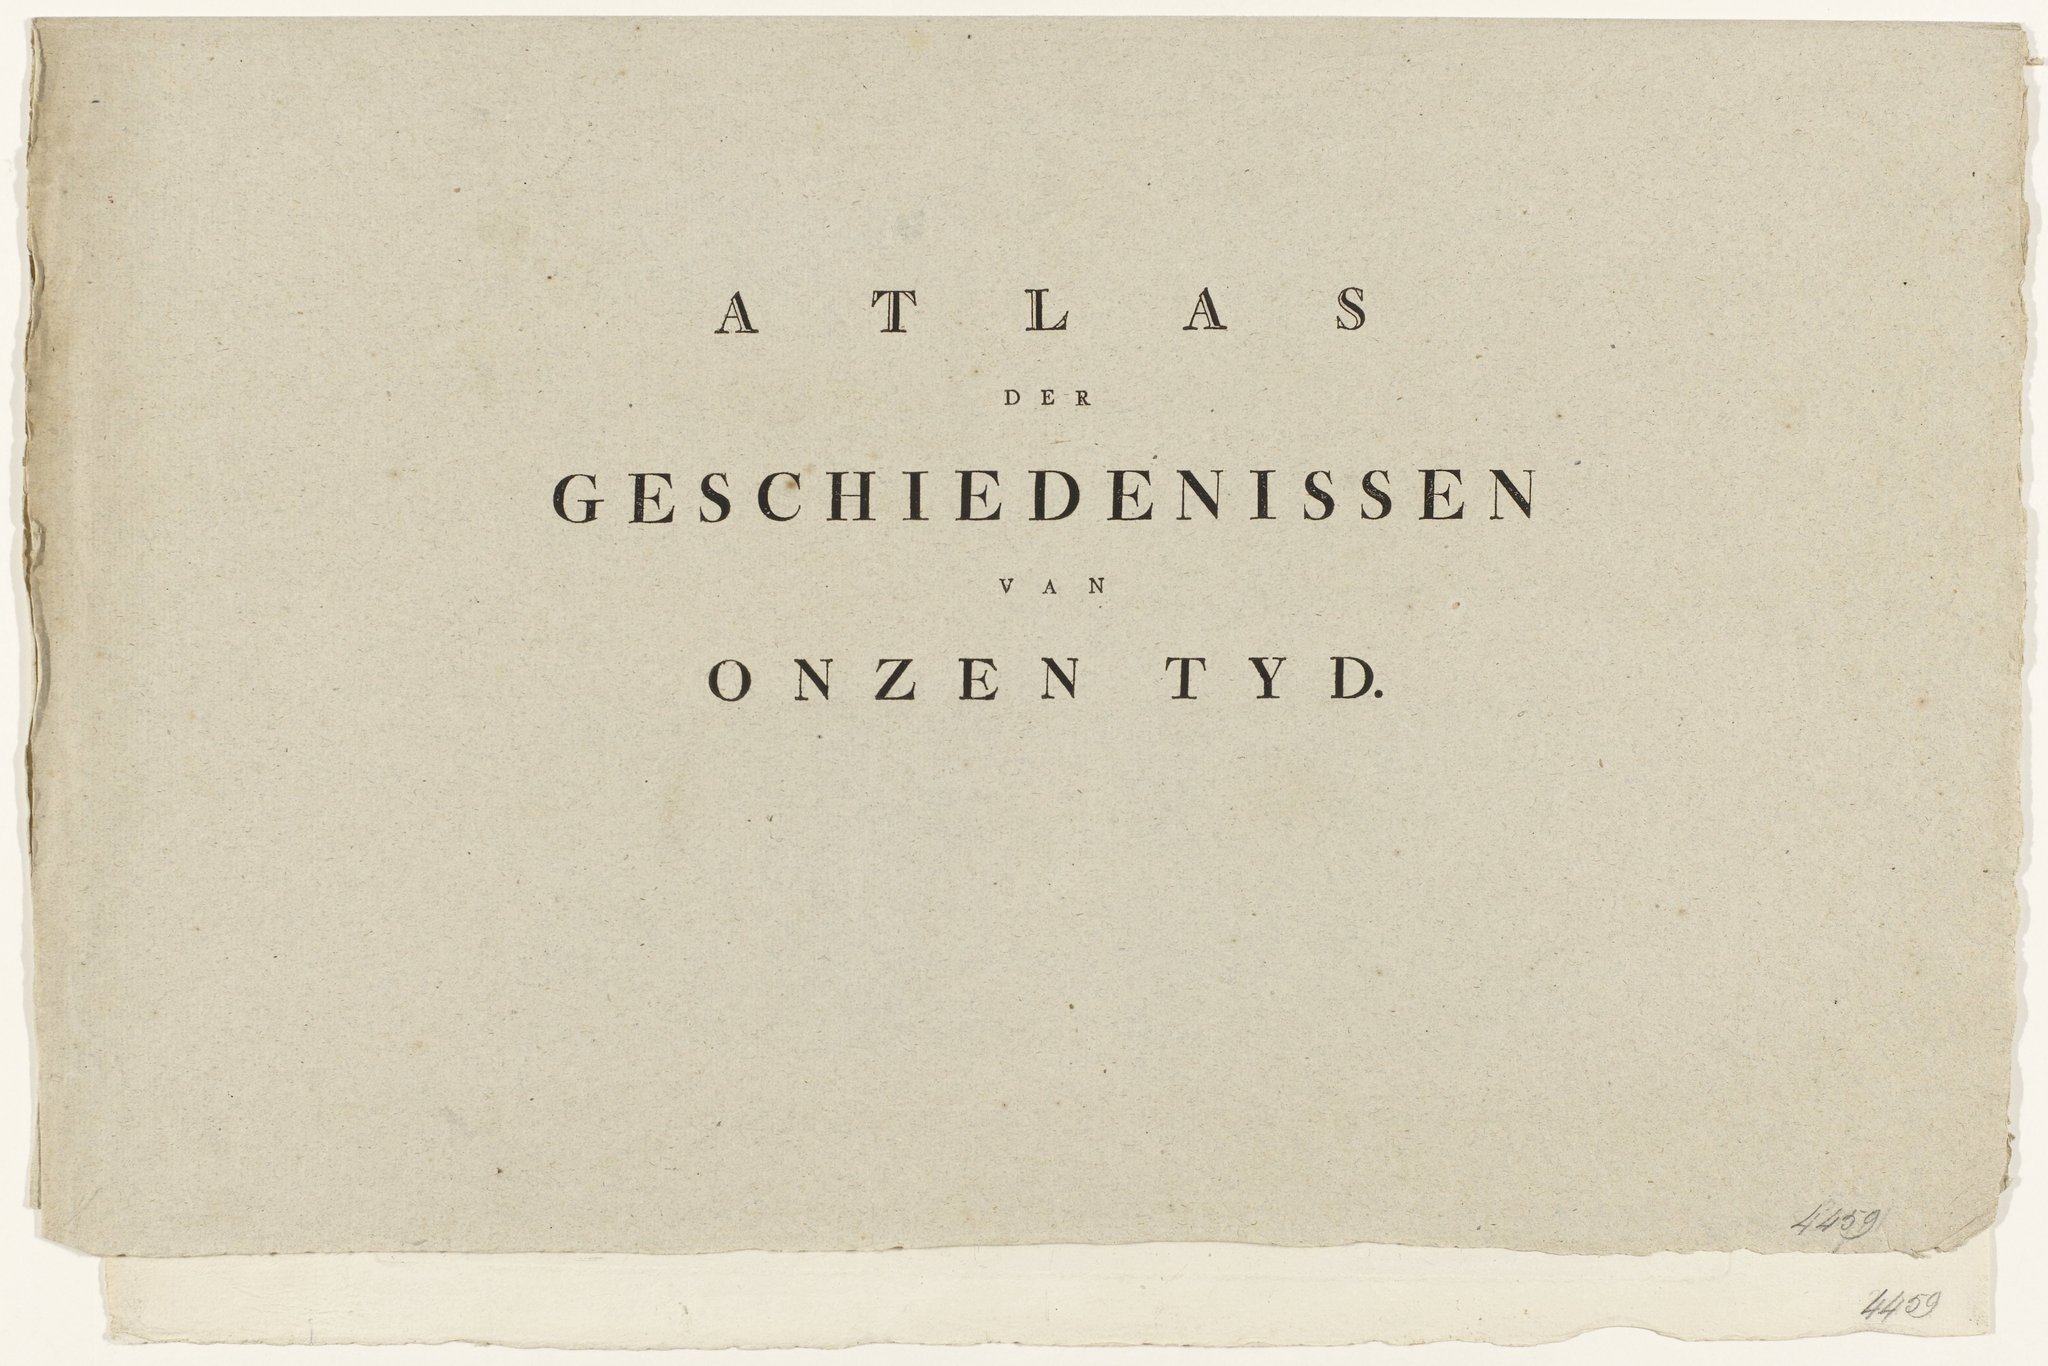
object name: text sheet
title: Atlas der Geschiedenissen van onzen tyd.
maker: willem kok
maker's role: draughtsman, print maker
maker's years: 1761-1807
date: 1787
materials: paper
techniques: letterpress printing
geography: northern netherlands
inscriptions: collector's mark: Lugt 2228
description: Dubbelgevouwen blad papier, de omslag voor de proefaflevering van een nieuwe reeks voorstellingen van historische gebeurtenissen uit de jaren 1780-1787, de reeks is na dit eerste nummer niet voortgezet.